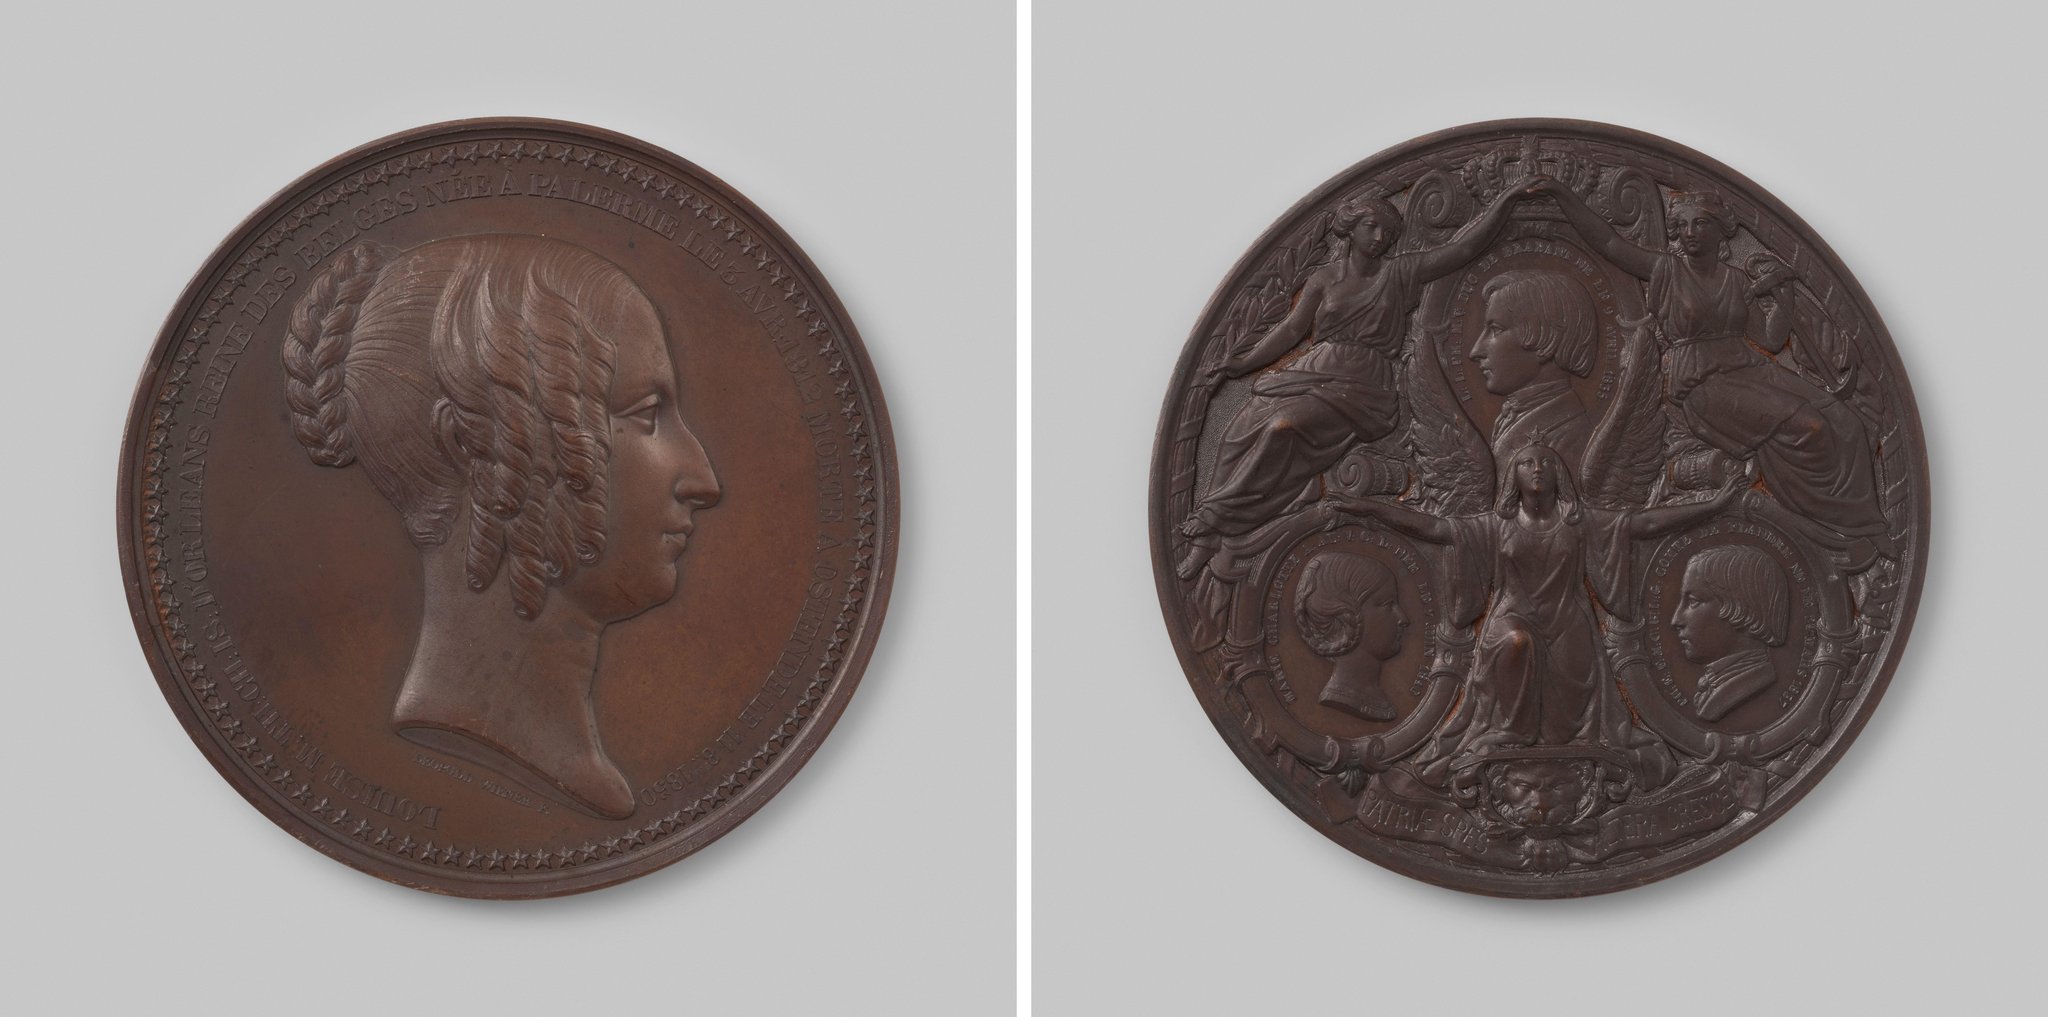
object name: history medal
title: Overlijden van Louisa Maria, koningin der Belgen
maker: leopold wiener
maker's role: sculptor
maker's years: 1823-1891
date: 1850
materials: bronze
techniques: striking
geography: brussels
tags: leopold ii (koning der belgen), laeken, brussels, louise marie van orléans (koningin van belgië)